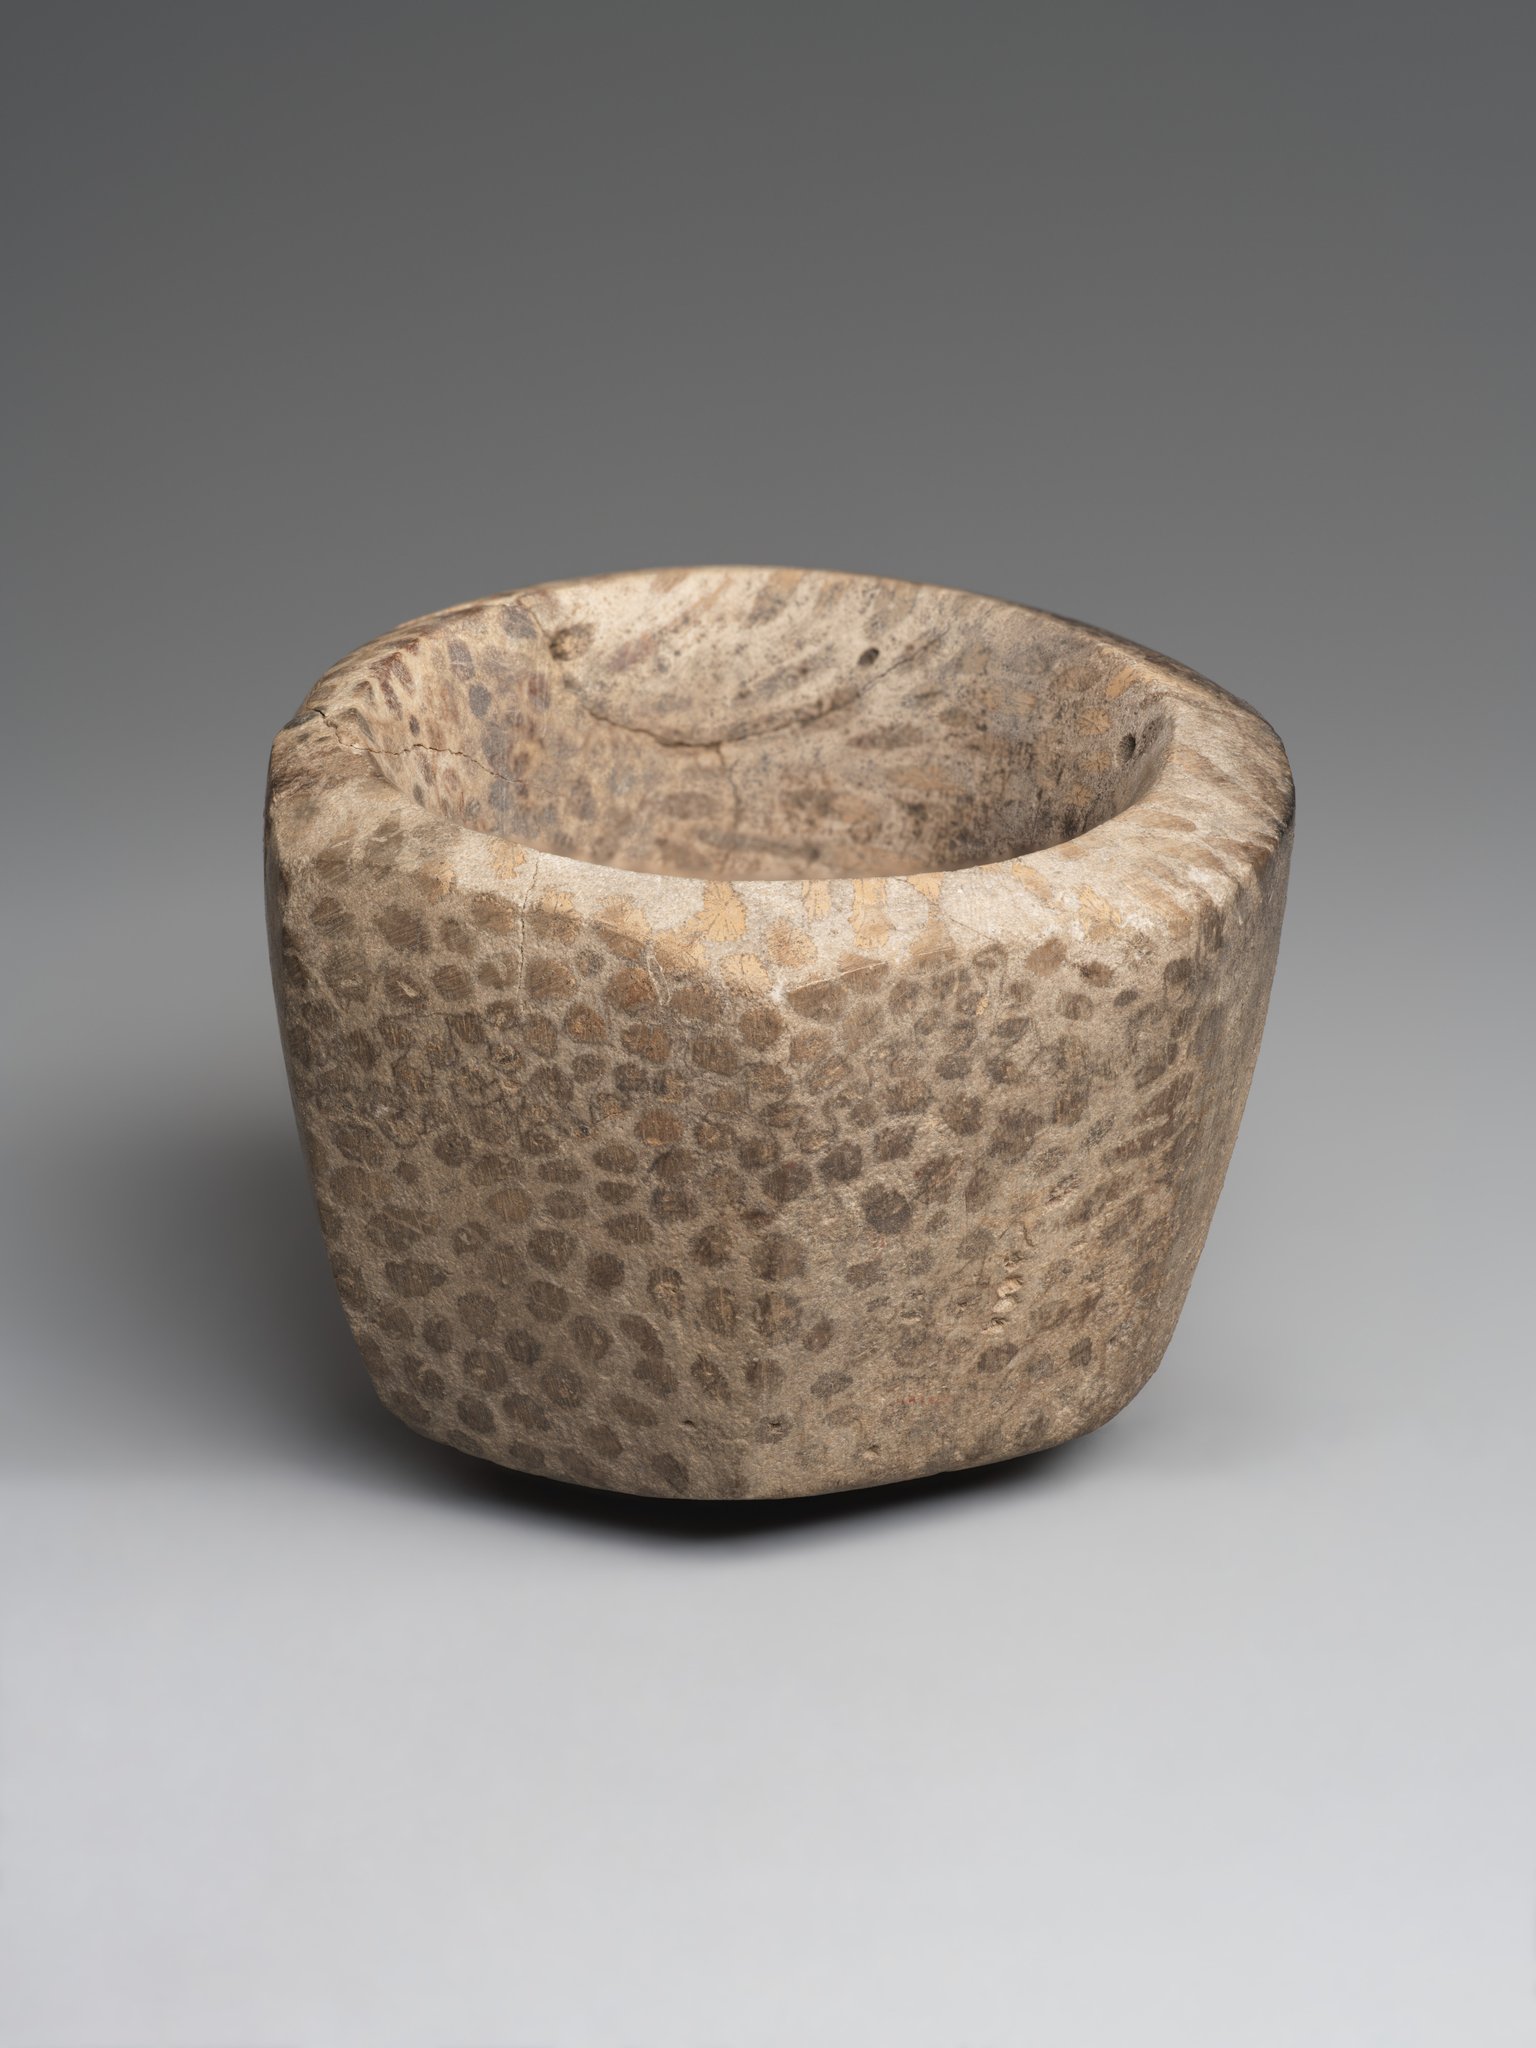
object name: bowl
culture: iranian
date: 900-801 BCE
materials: coral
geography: iran